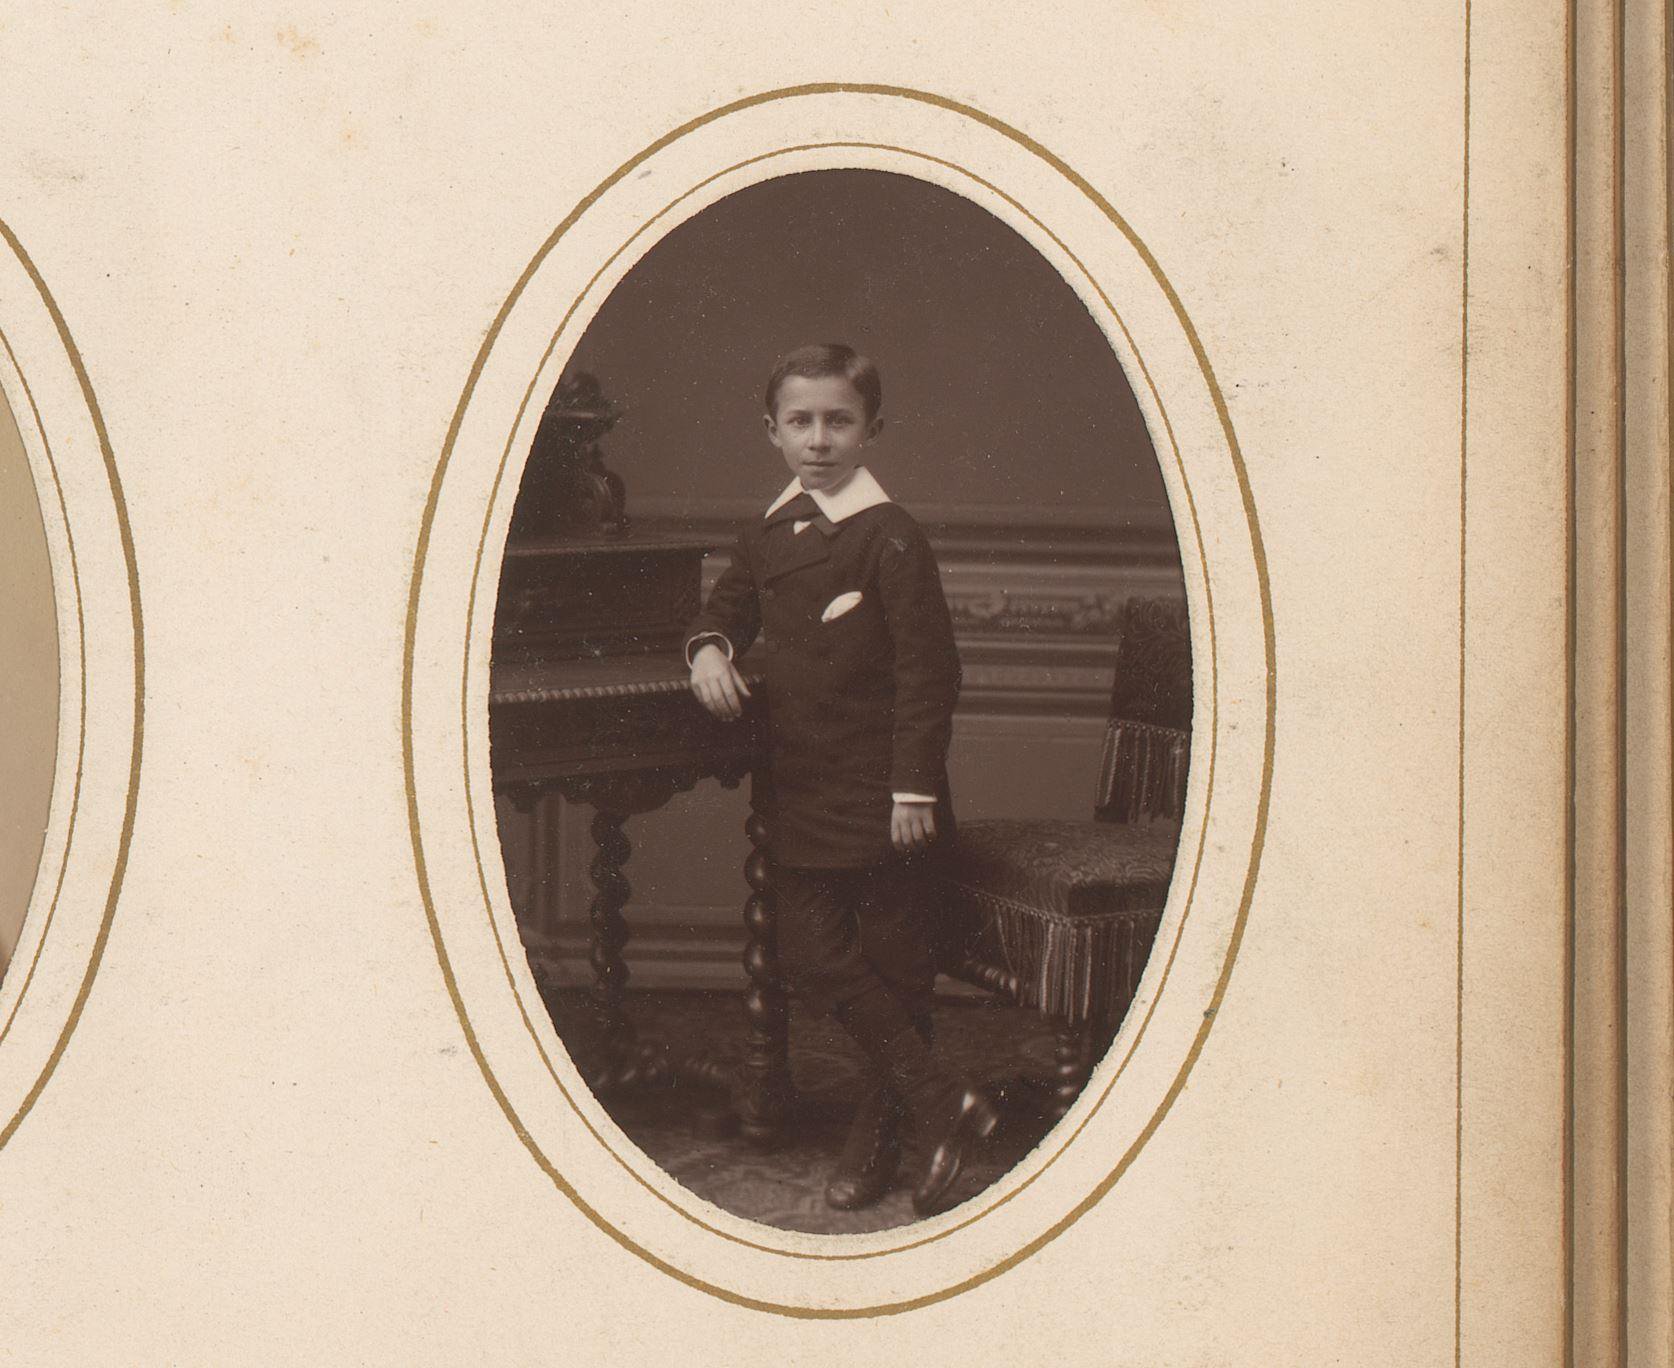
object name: album leaf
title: Portret van een jongen, leunend op een tafel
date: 1878-1890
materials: cardboard, paper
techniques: carbon print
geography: brussels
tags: boy (child between toddler and youth), historical persons, table, chair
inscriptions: inscription: ‘PROCÉDÉ INALTÉRABLE/ Photographie au Charbon/ (...)/ Géruzet Frères/ Photographes de S.M. la Reine des Belges/ 27B, Rue de l'Ecuyer/ Bruxelles/ Les Clichés sont conservés.’